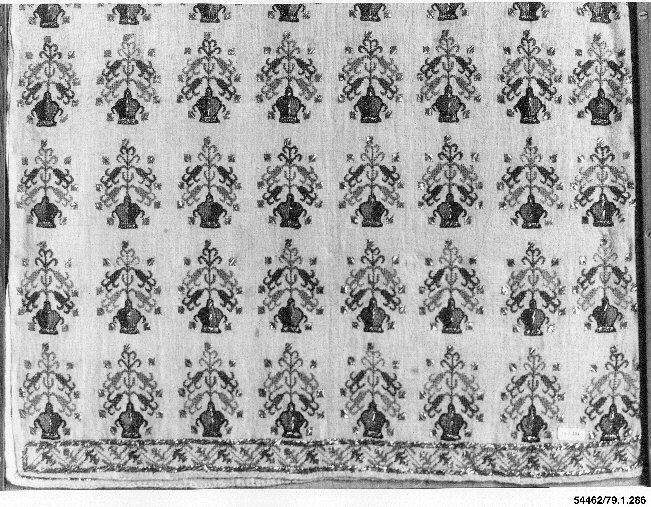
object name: cover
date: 1801-1833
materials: linen, metal thread, silk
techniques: embroidery, weave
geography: turkey